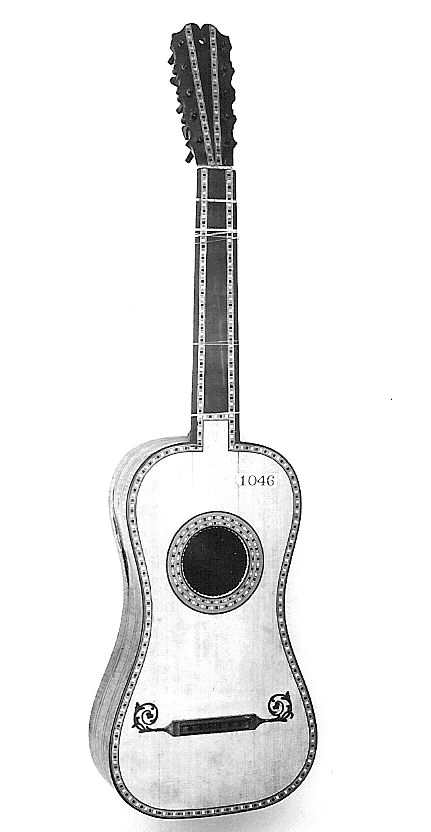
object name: guitar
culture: belgian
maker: guillaume joseph lekeu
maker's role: maker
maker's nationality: belgian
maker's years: 1767-1800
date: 1770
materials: wood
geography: belgium